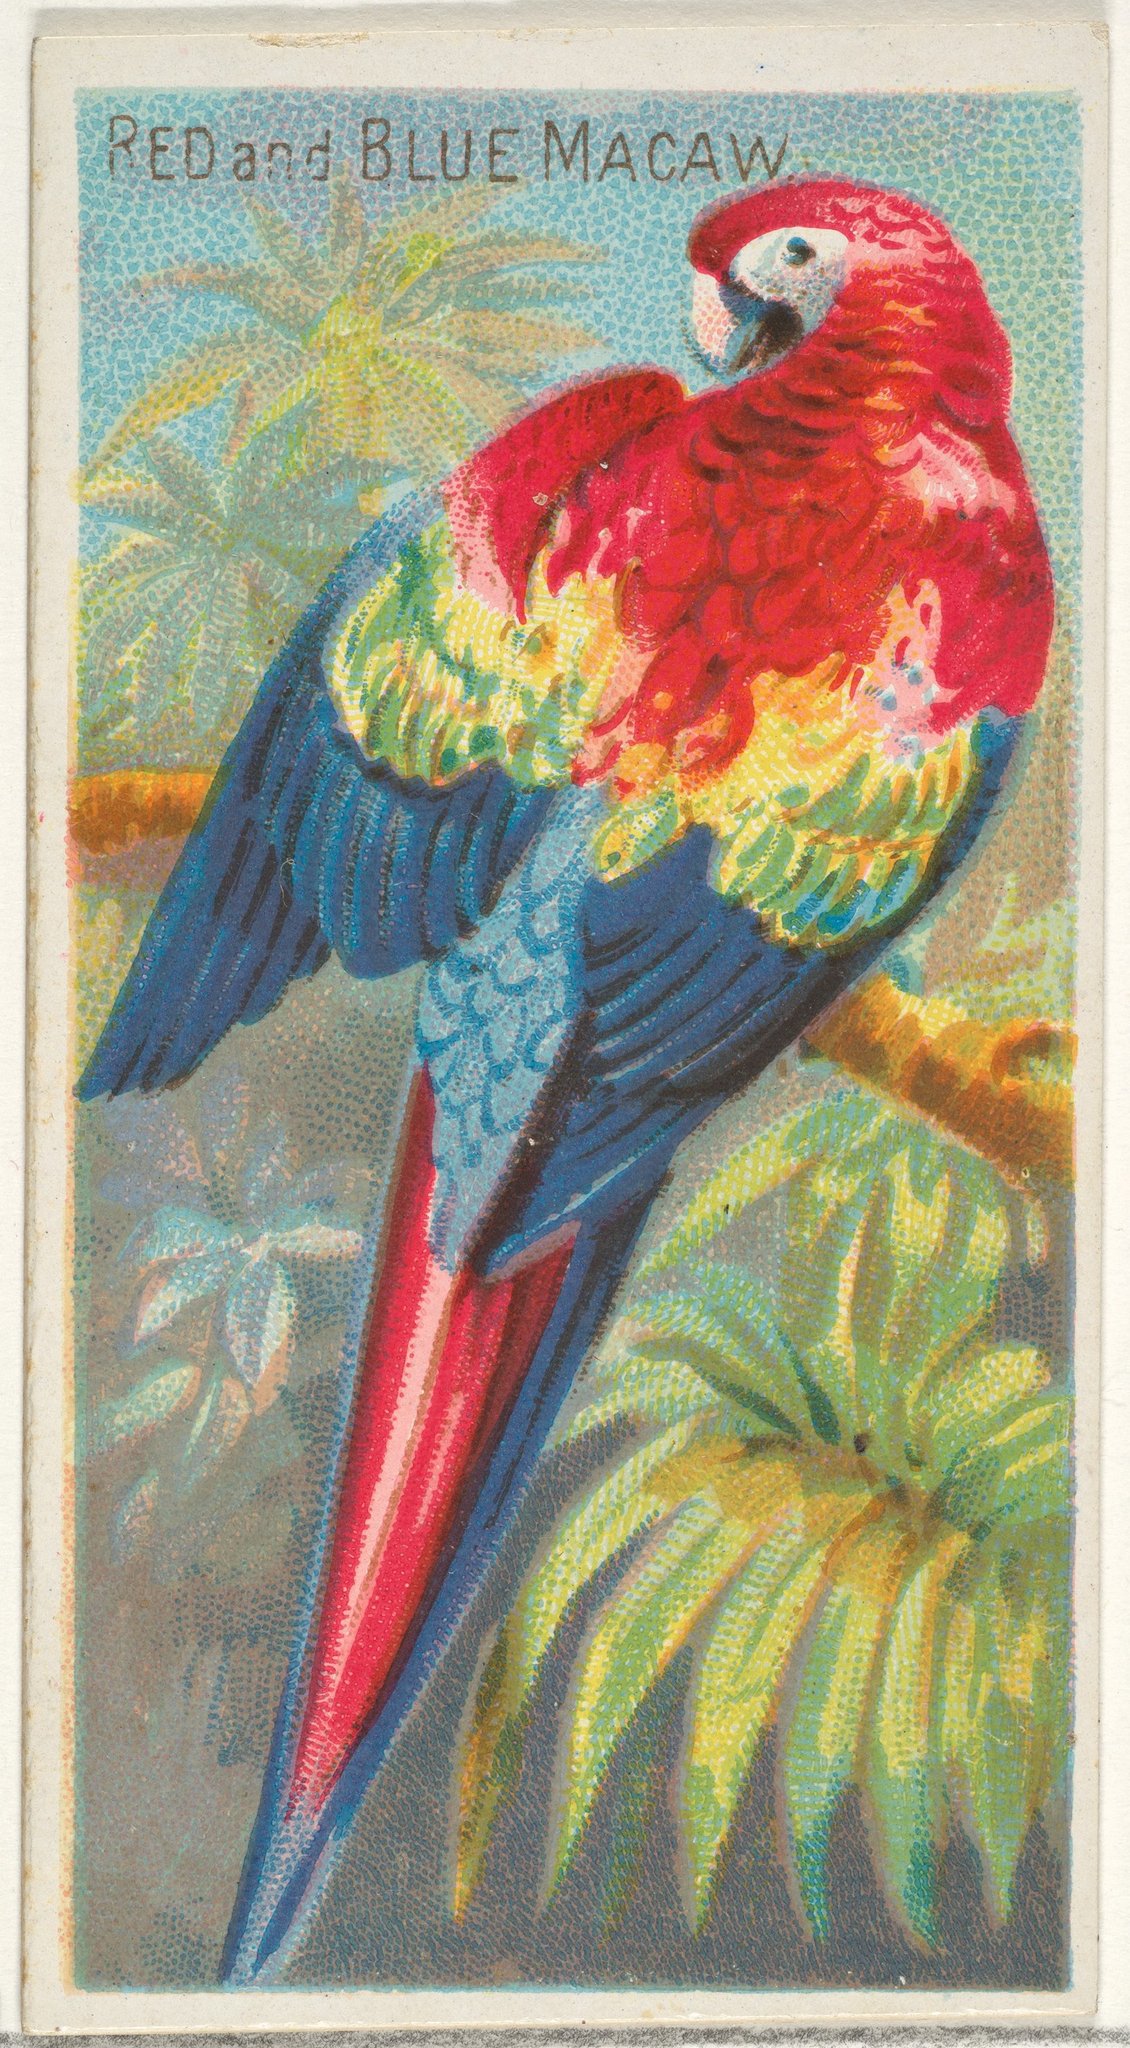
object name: print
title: Red and Blue Macaw, from the Birds of the Tropics series (N5) for Allen & Ginter Cigarettes Brands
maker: allen & ginter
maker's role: publisher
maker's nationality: american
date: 1889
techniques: color lithograph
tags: birds